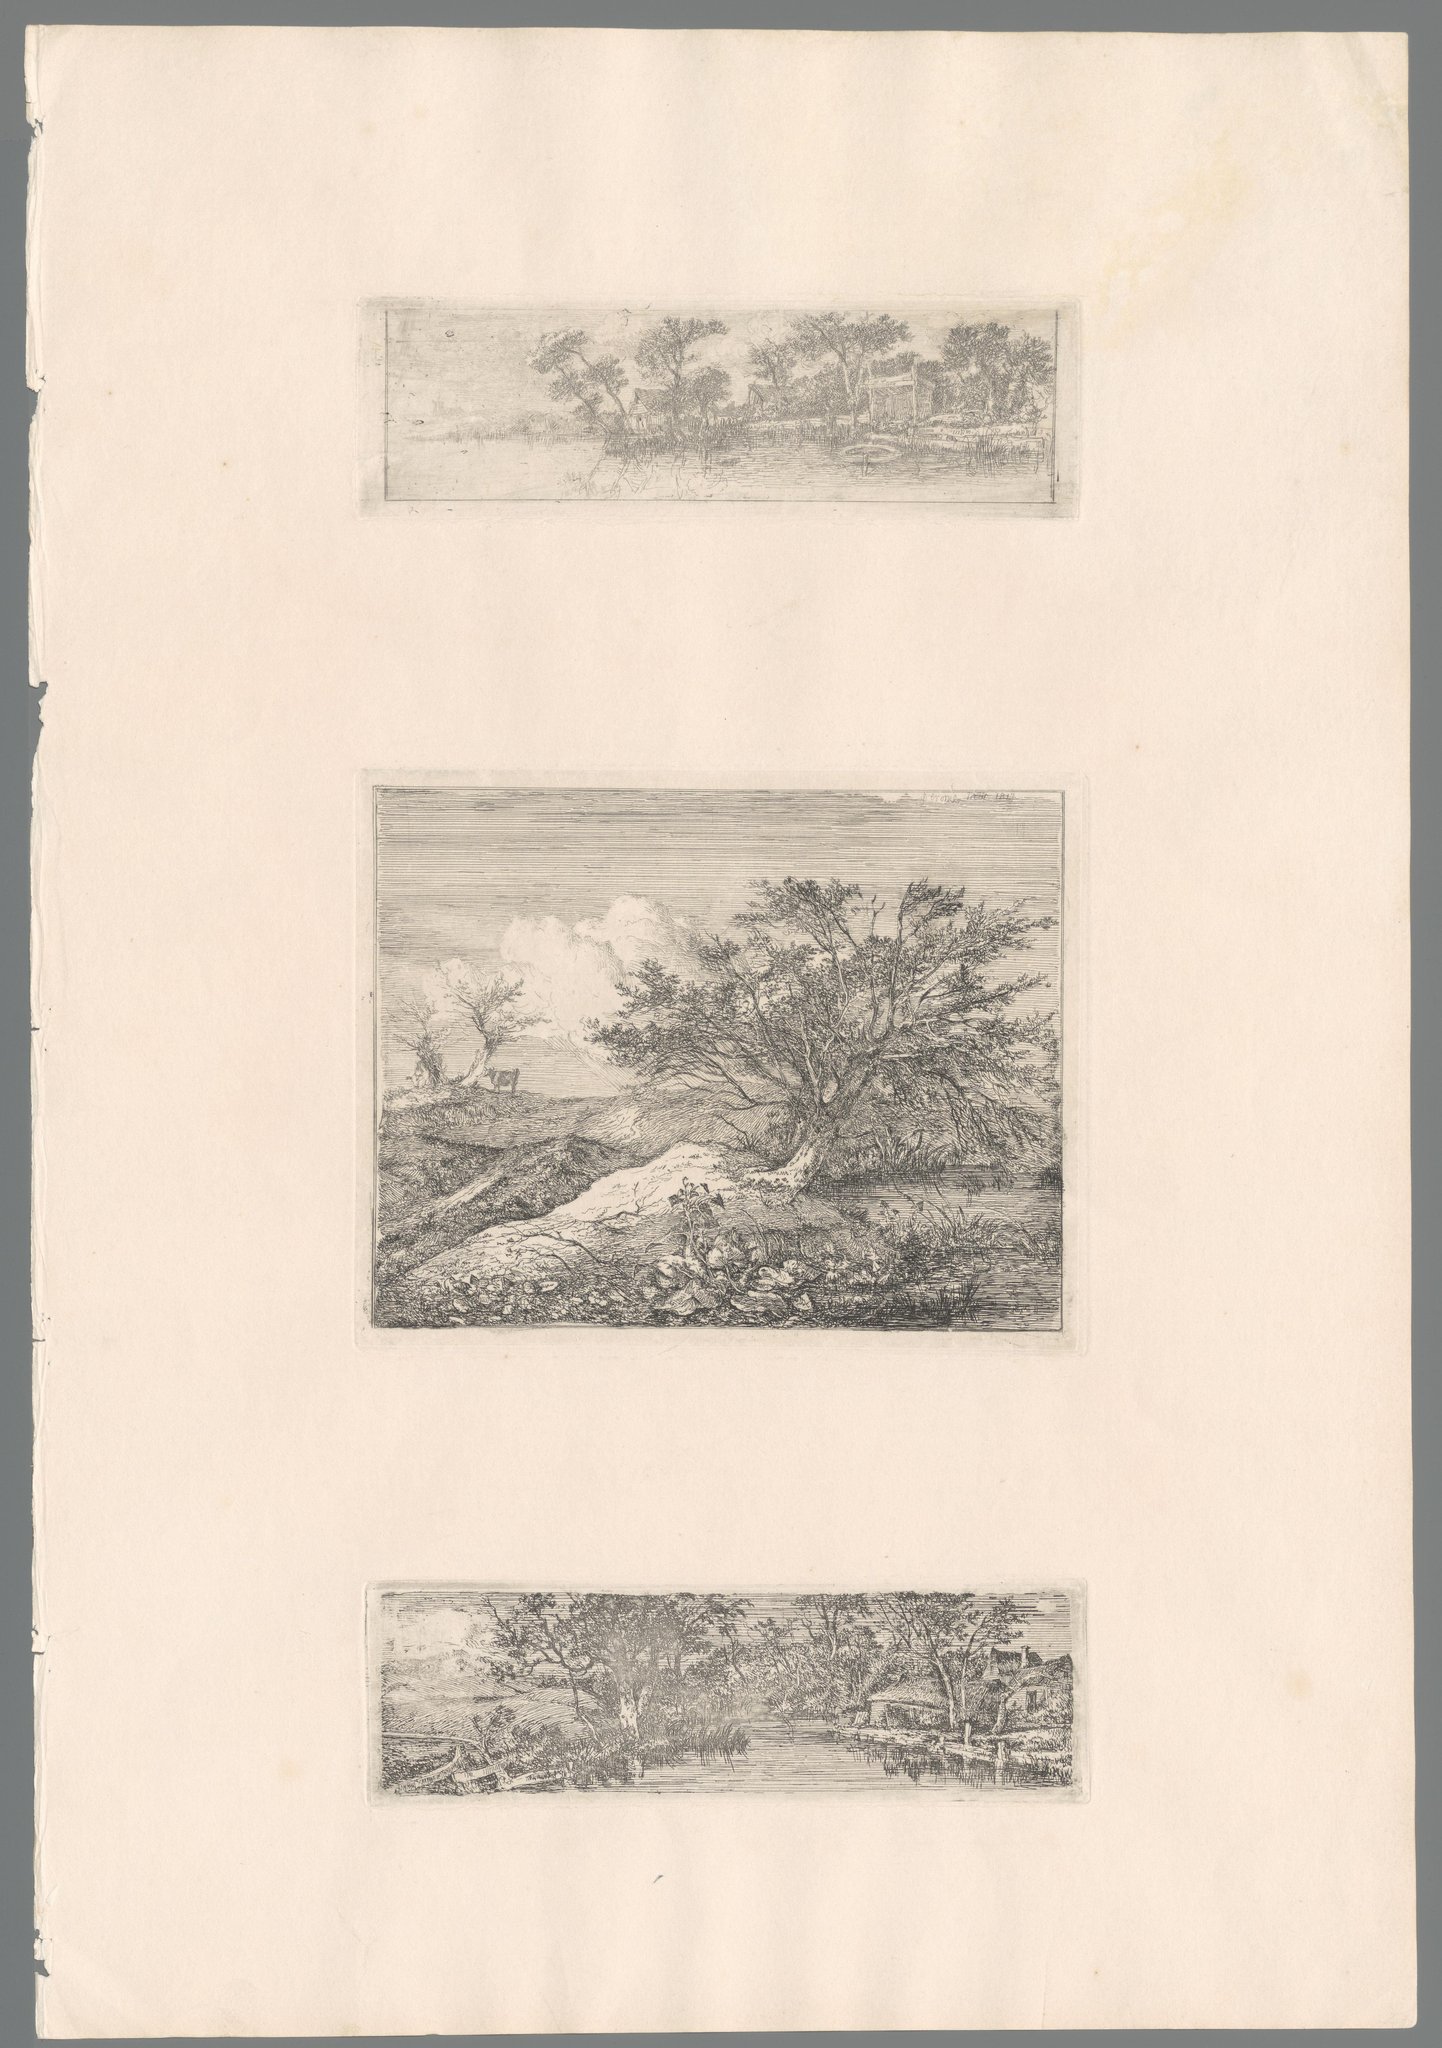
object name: print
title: Norfolk Picturesque Scenery (...) thirty-one etchings, by the late John Crome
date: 1834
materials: paper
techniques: etching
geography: norwich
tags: pool, puddle, farm (building)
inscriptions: collector's mark: Lugt 2228, collector's mark: Lugt 2760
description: Prent staat samen met RP-P-1973-185 en RP-P-1973-186 op een onversneden blad.